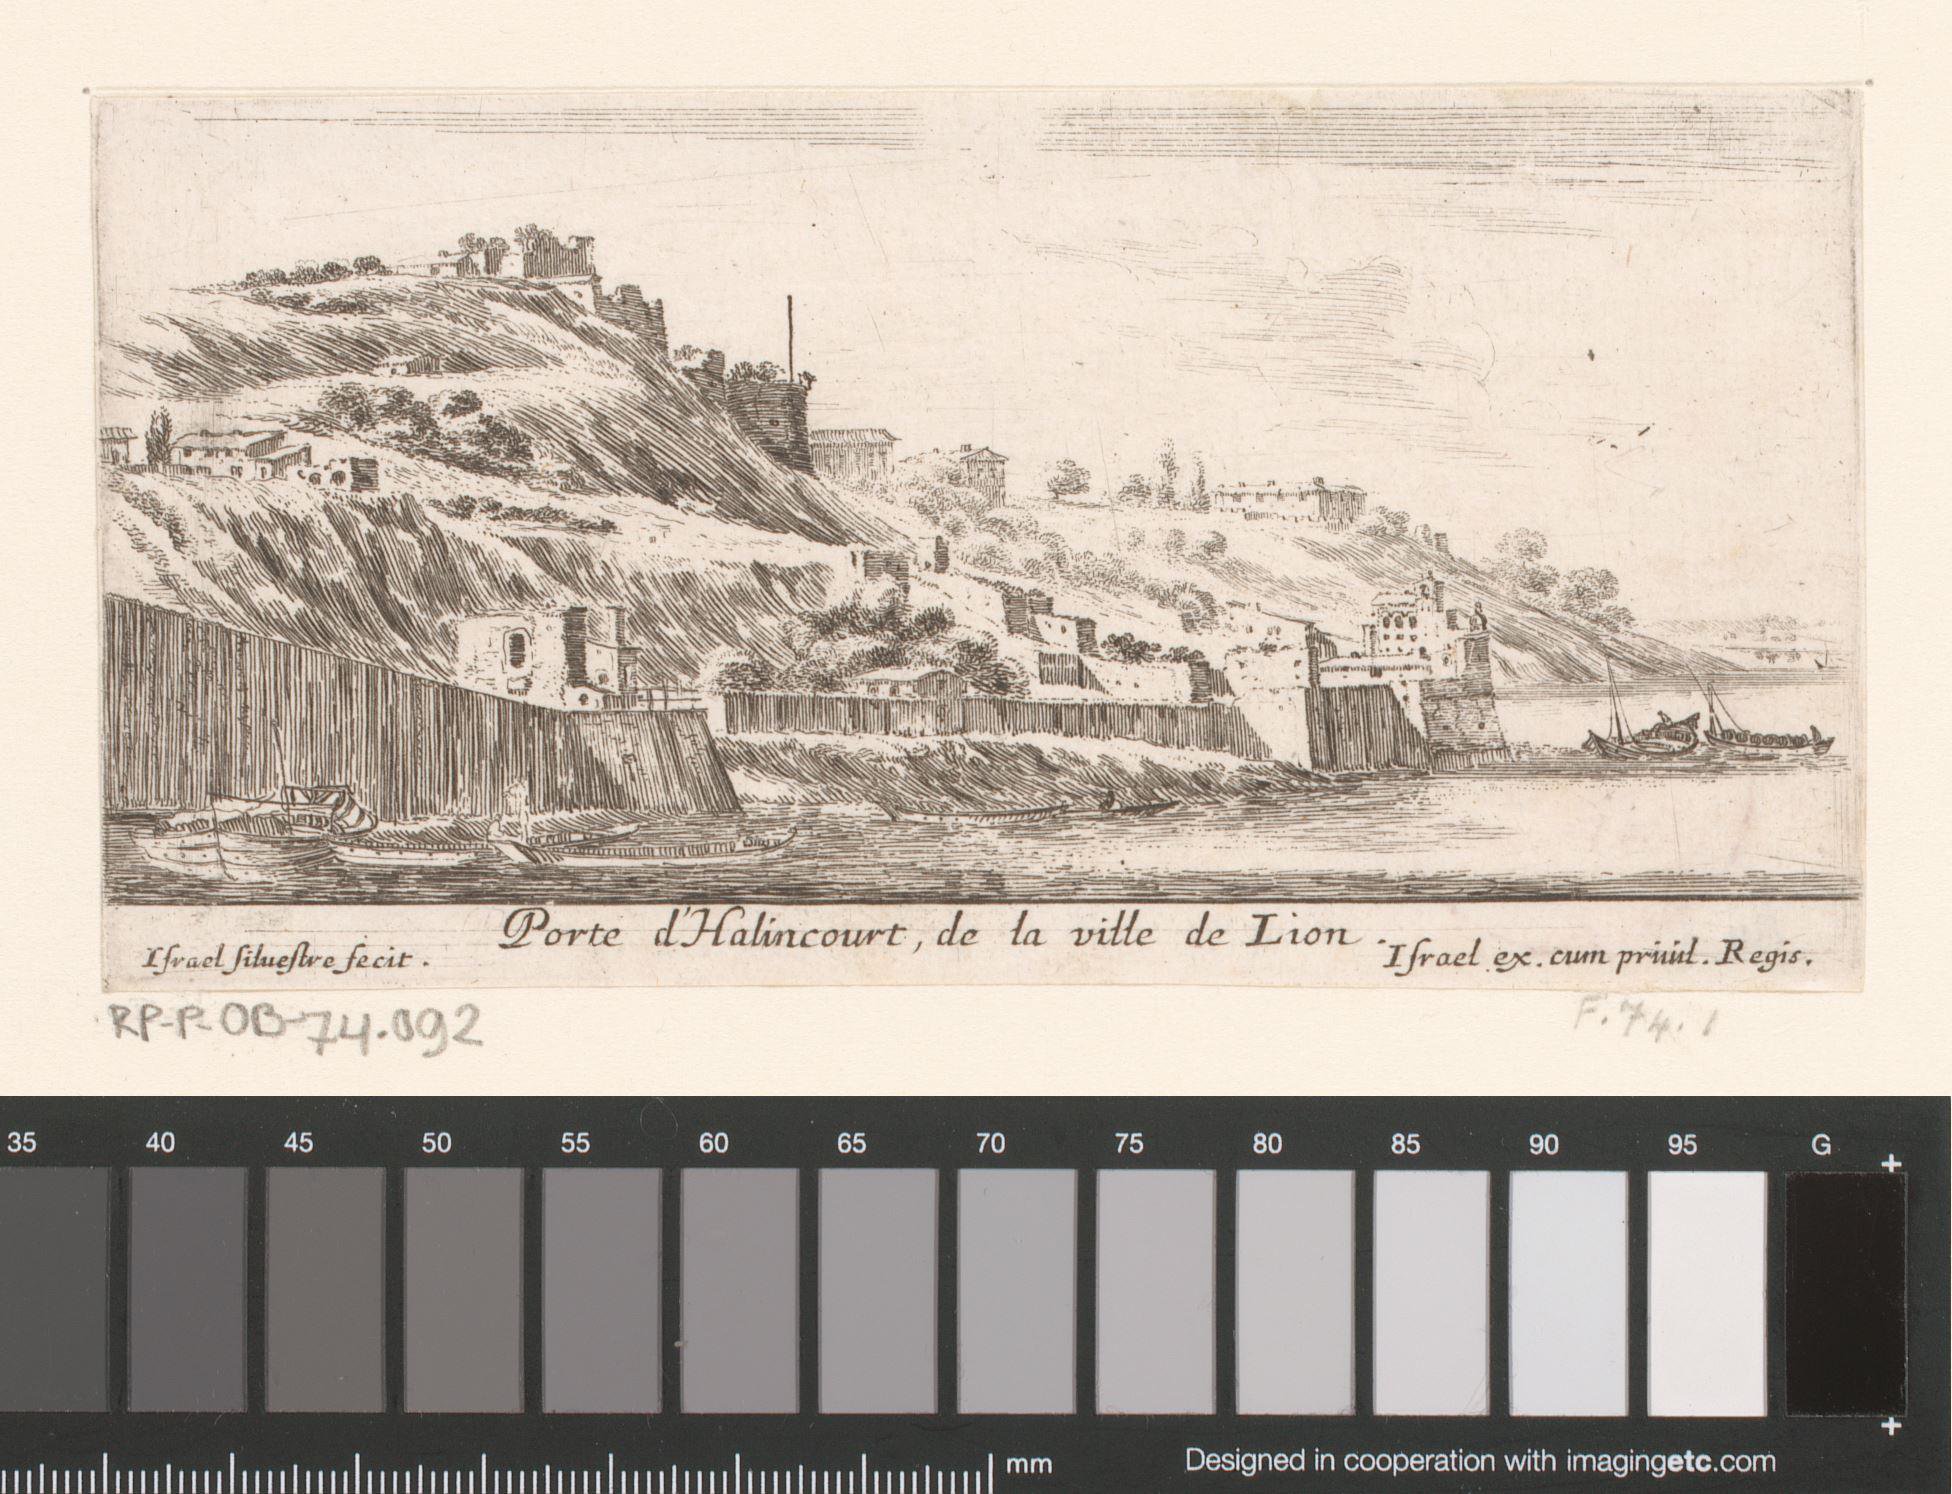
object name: print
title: Gezicht op de haven van Halincourt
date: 1631-1661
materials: paper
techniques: etching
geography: france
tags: harbour, city-view, and landscape with man-made constructions (+ city(-scape) with figures, staffage), lyon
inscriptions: collector's mark: Lugt 240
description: Prent maakt deel uit van een ongenummerde serie van zeven prenten.